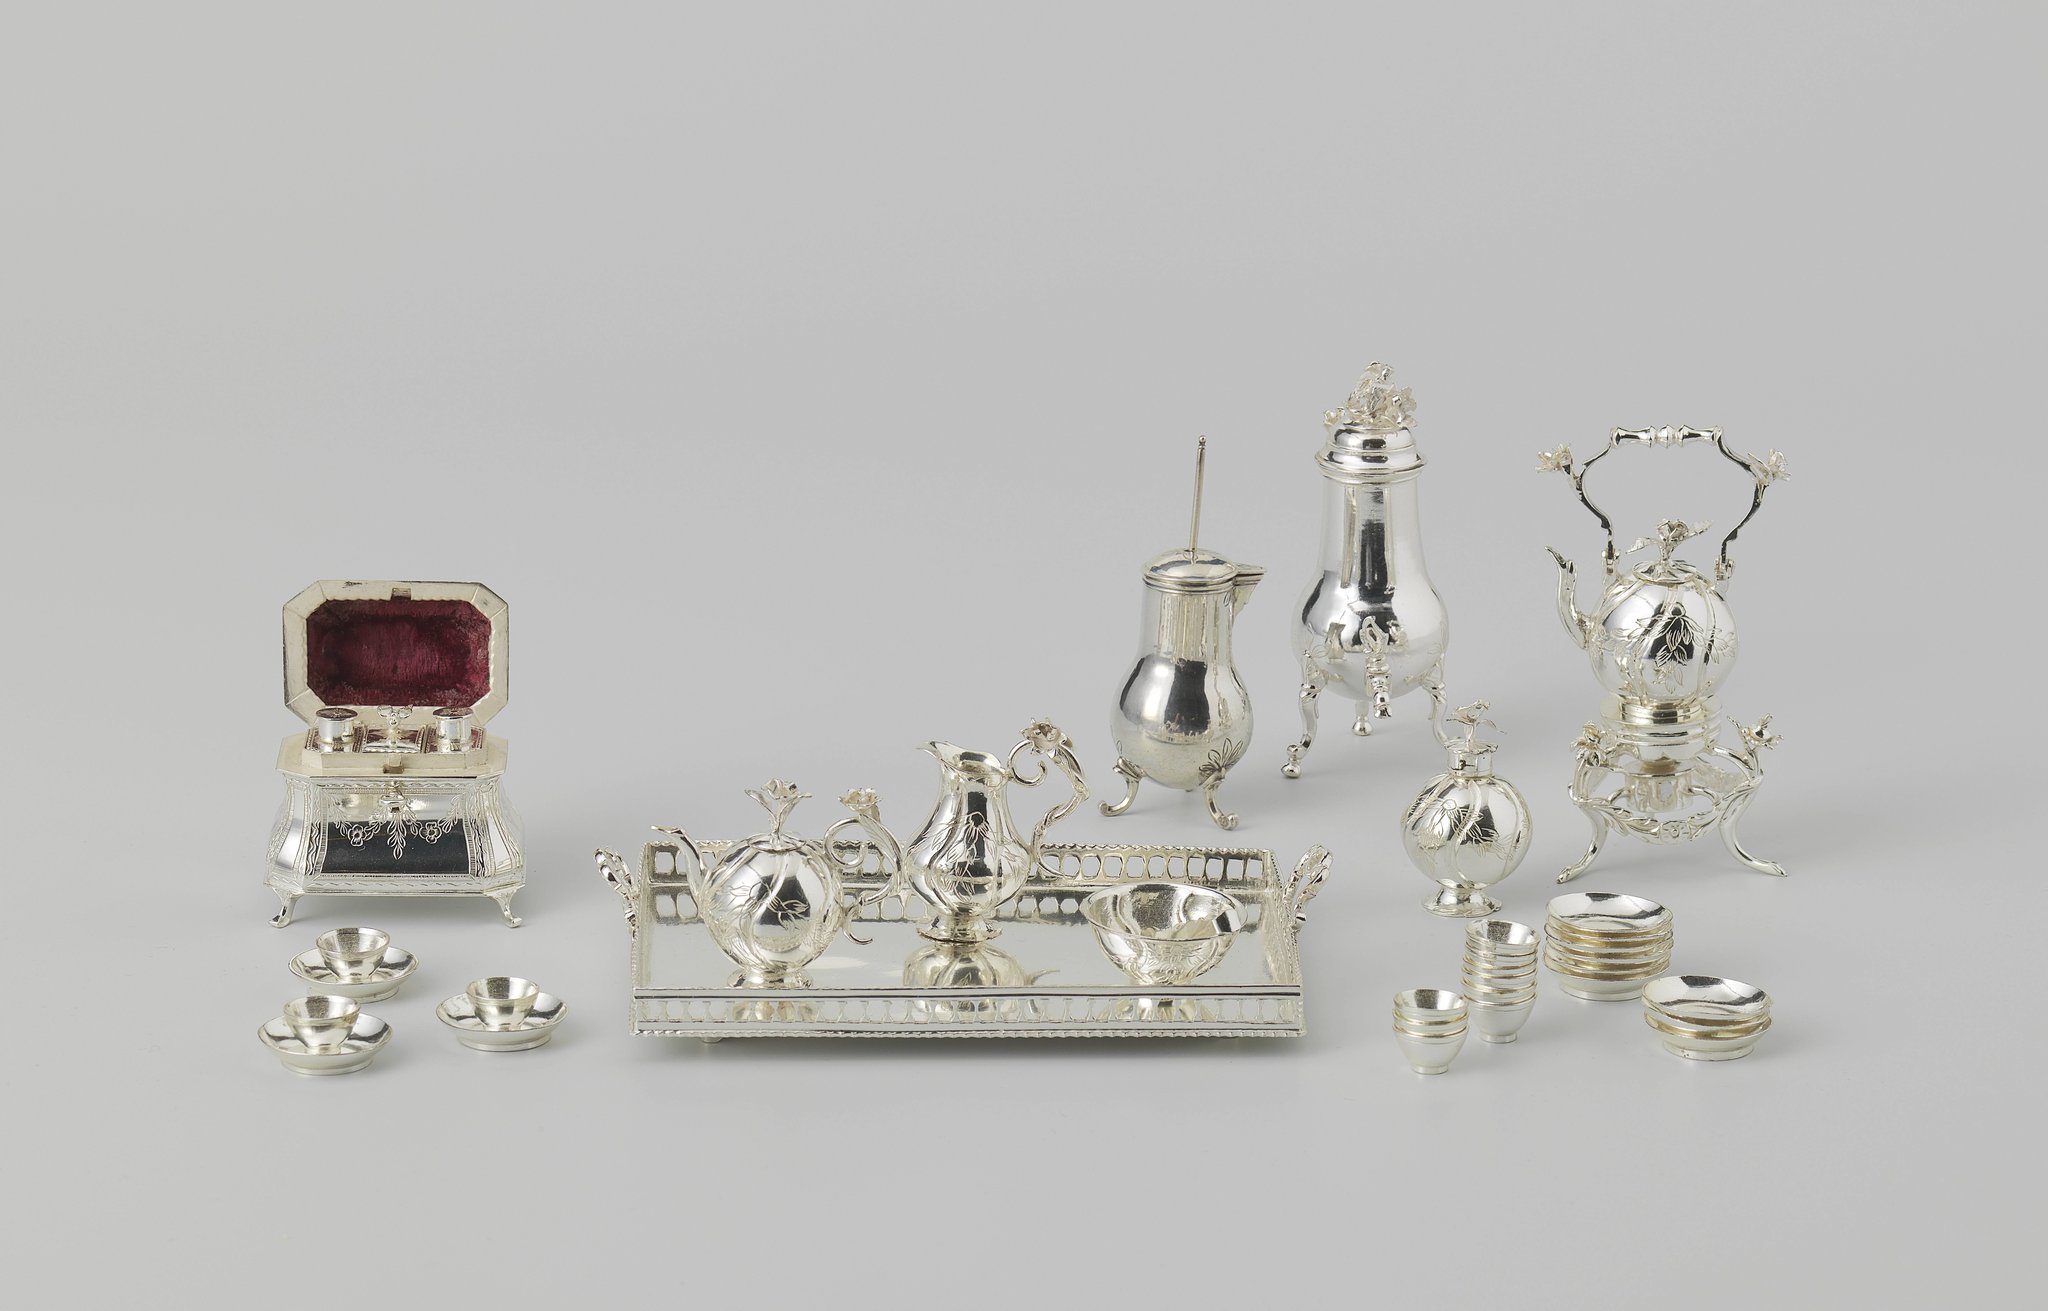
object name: miniature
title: Kop-en-schotel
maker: Anonymous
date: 1775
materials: silver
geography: amsterdam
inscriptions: maker's mark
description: Trechtervormige theekop op een schotel. De schotel heeft een opstaande rand, is onversierd en gemerkt: mt.= Voet 430. De theekop is langs de bovenrand gegraveerd en is niet gemerkt. De kop en schotel worden bewaard als onderdeel van een theeservies (BK-NM-11177-142). Het theeservies heeft in het totaal twaalf kop en schotels die gelijk zijn aan dit exemplaar.